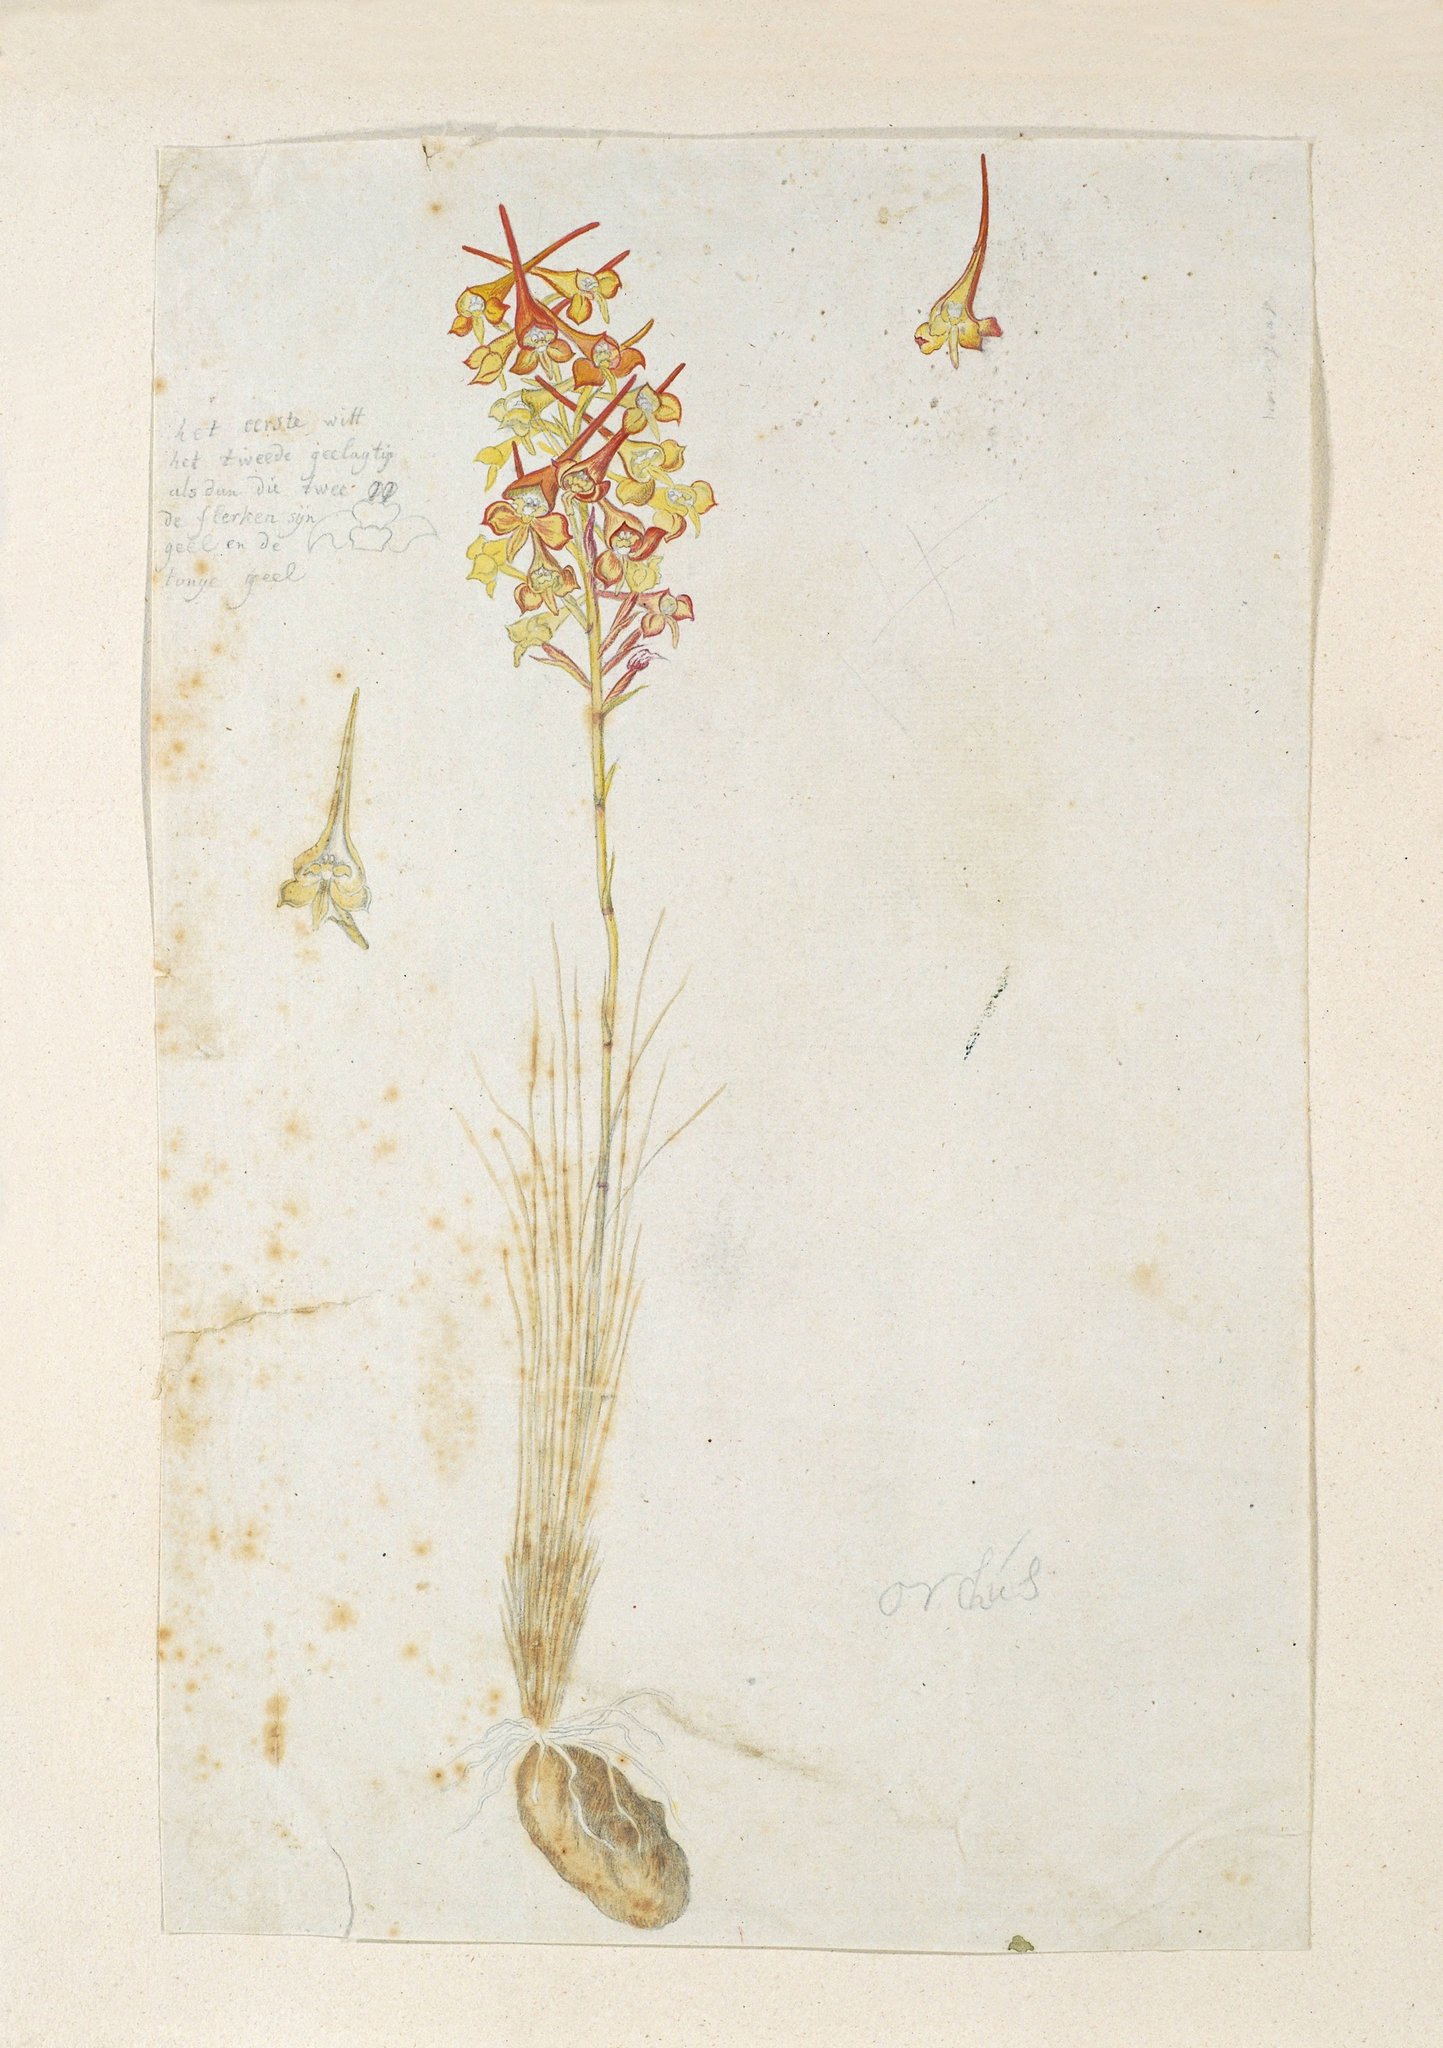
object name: album leaf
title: Disa porrecta Swartz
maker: robert jacob gordon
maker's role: draughtsman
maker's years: 1743-1795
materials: chalk, paper, pencil, watercolor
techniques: brush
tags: plants; vegetation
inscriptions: annotation: ‘het eerste witt / het tweede geelagtig /als dan die Twee- /de flerken sijn / geel en de / tonge geel; orchus’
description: De tekening is gemaakt voor of tijdens een van Gordon's vier expedities door de Kaapprovincie, van oktober 1777 tot maart 1786. Sommige (soort)namen kunnen zijn gewijzigd, gezien reorganisatie in plantentaxonomie gedurende de afgelopen jaren.